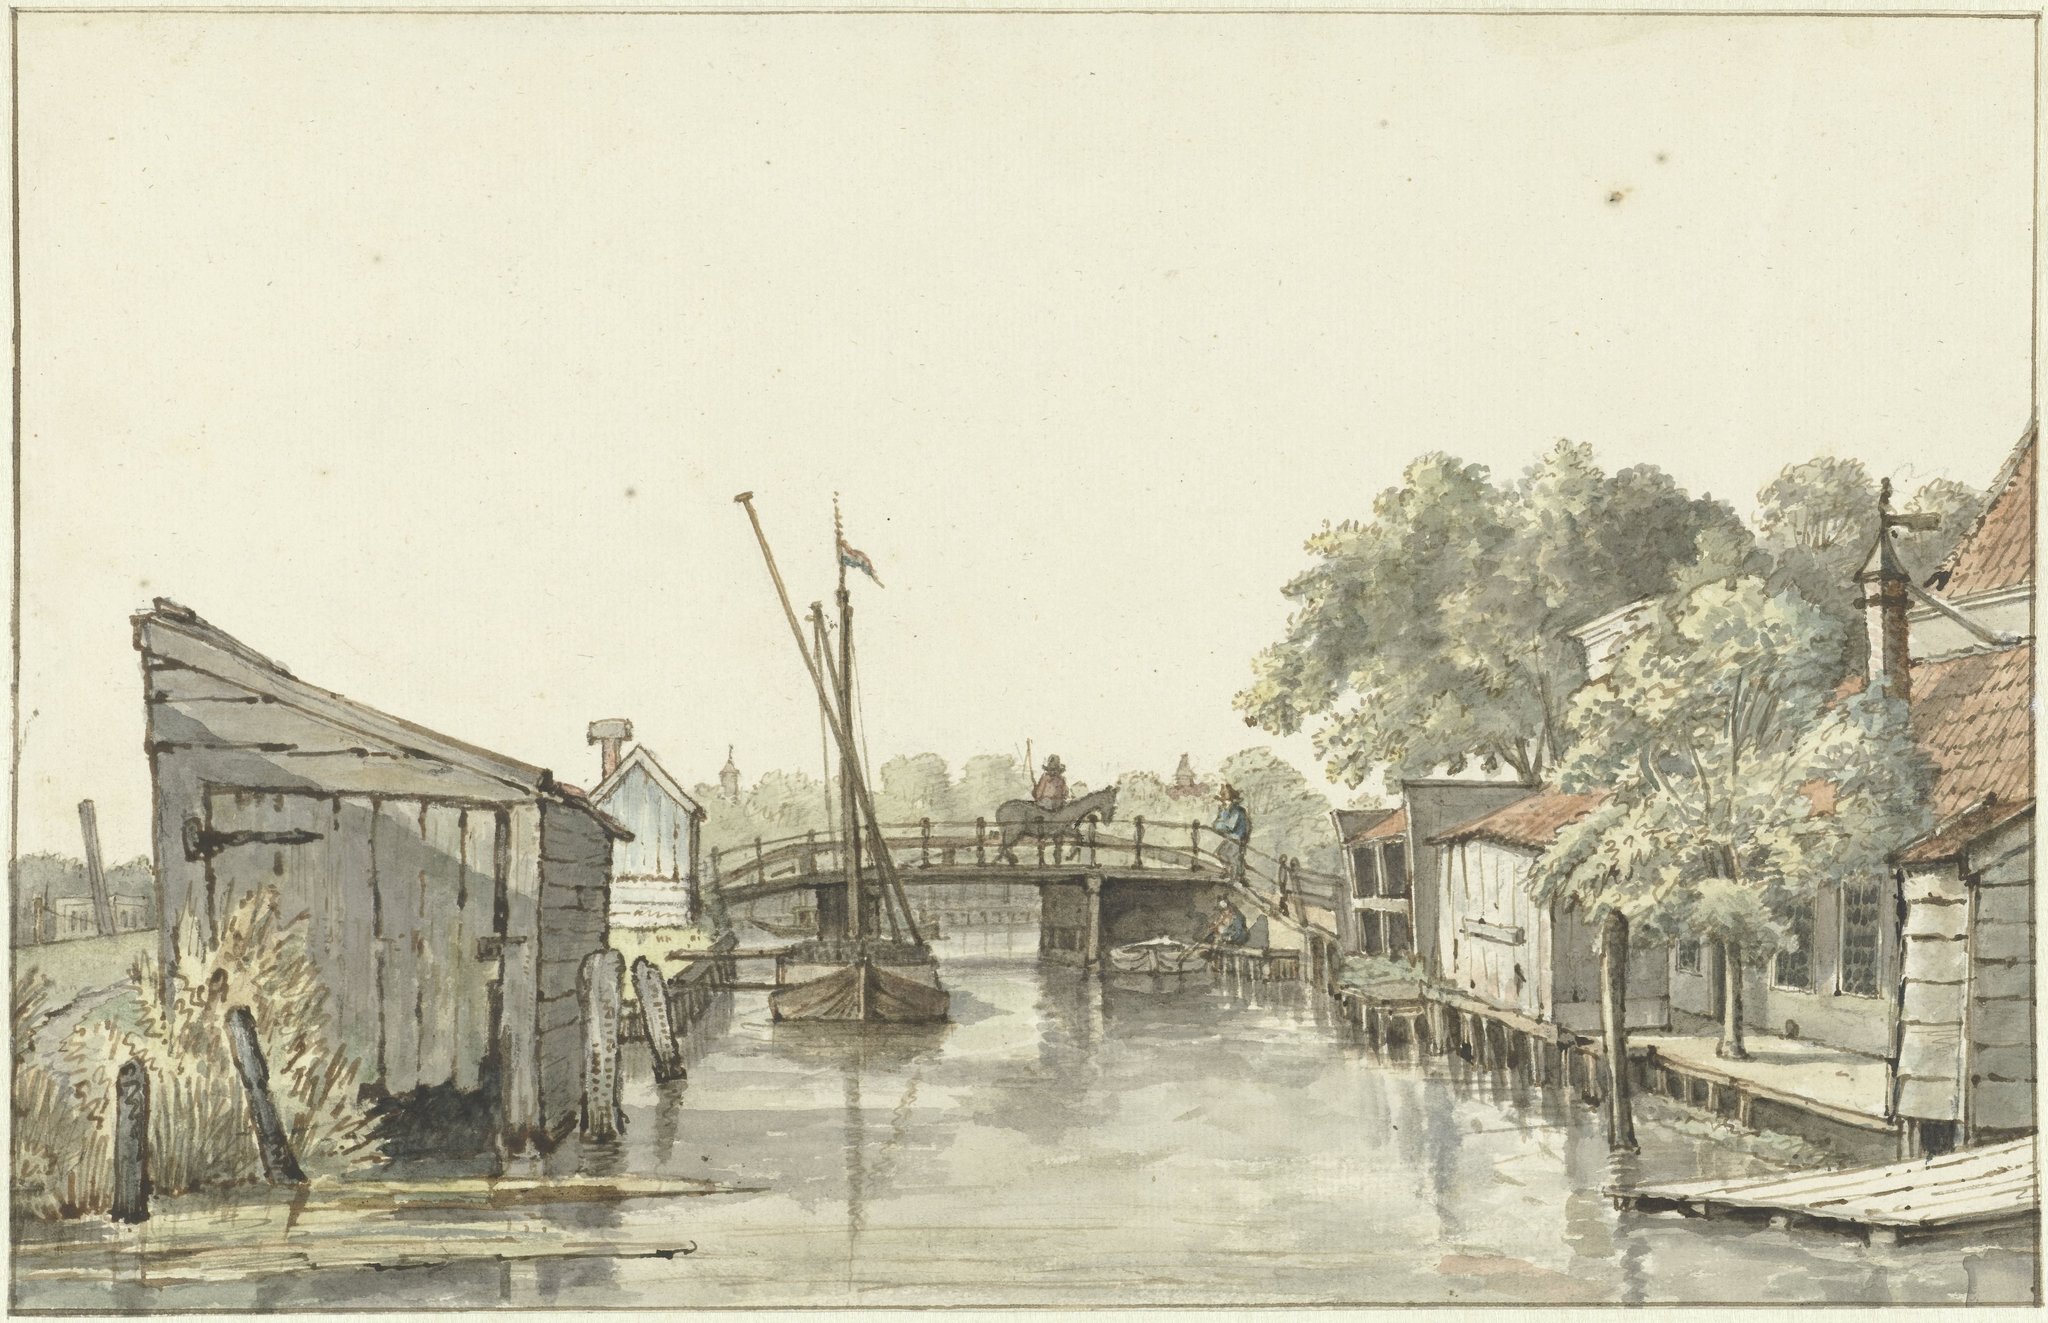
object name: drawing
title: Gezicht van de Ringdijk op de Schulpbrug, ziende naar de Utrechtse zijde van de Amstel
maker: gerrit lamberts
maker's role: bookseller, draughtsman, print maker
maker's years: 1776-1850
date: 1817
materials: chalk, ink, paper, watercolor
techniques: brush, pen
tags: landscape with bridge, viaduct or aqueduct